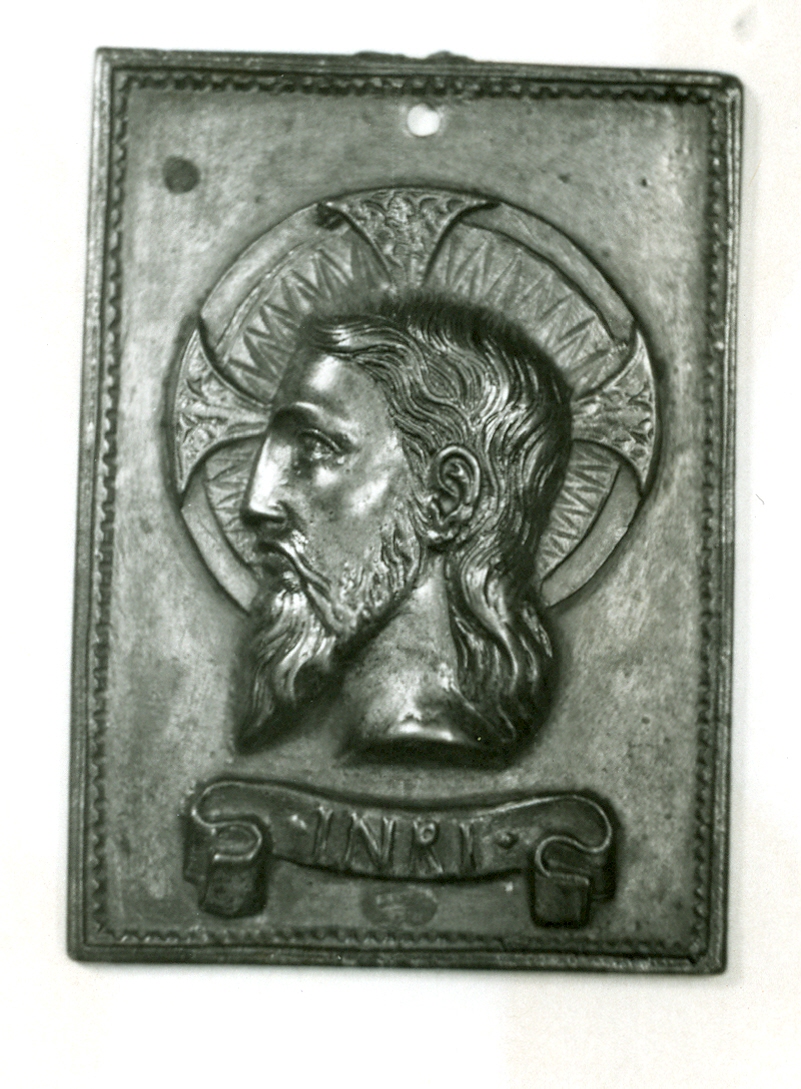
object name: plaquette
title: Head of Christ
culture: italian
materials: copper alloy, lead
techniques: silvered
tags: christ